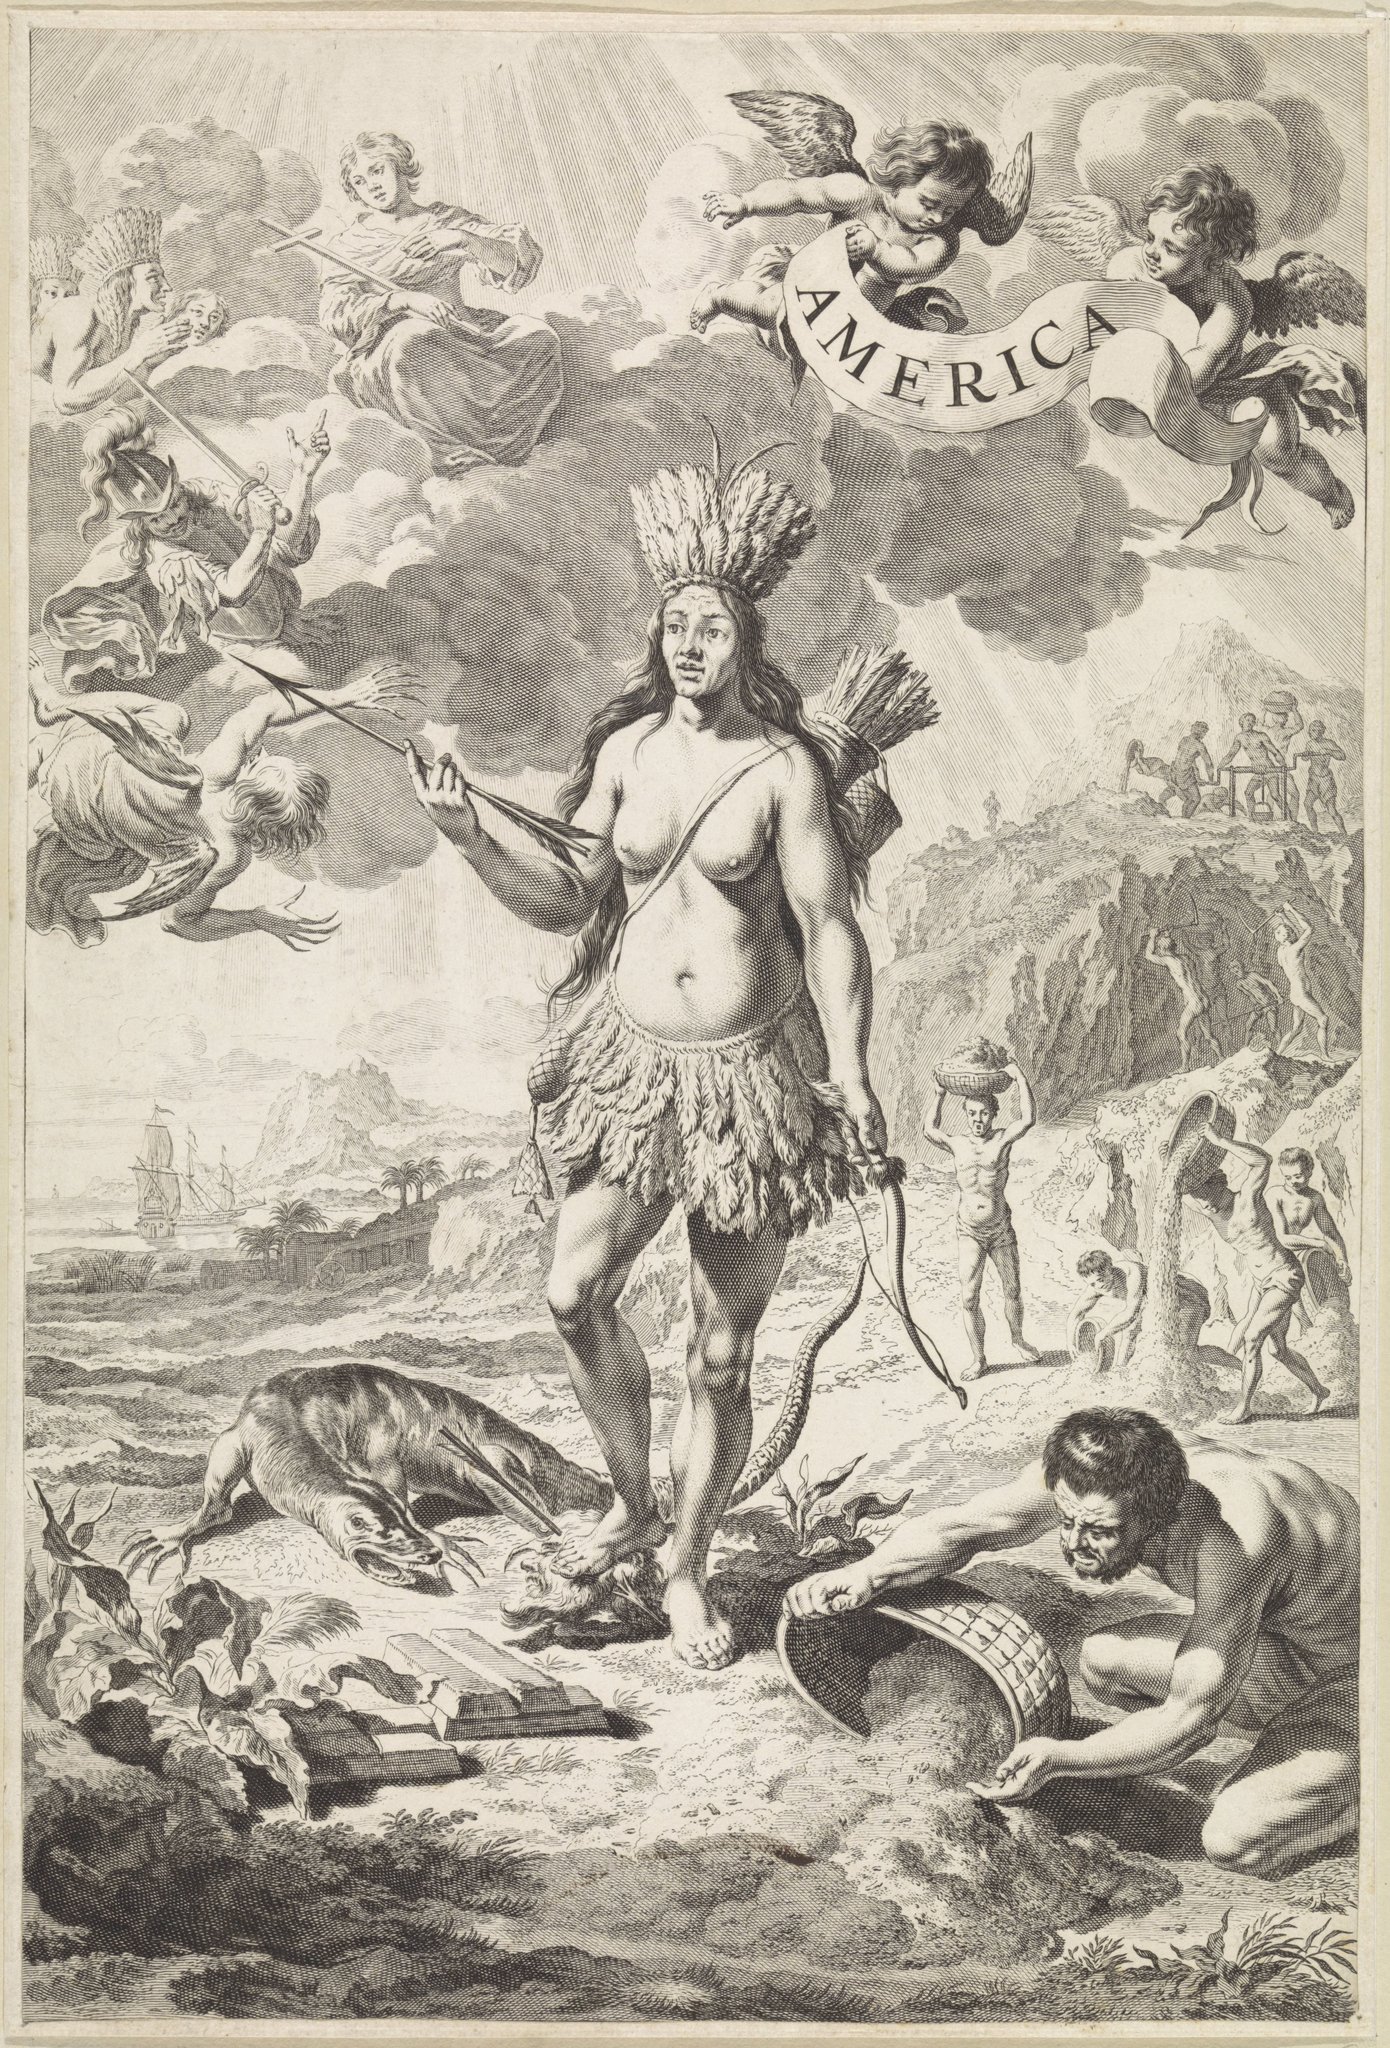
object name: print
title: Zuid Amerikaans landschap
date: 1650-1700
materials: paper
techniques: engraving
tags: sail, indigenous peoples of south america, cupids: 'amores', 'amoretti', 'putti'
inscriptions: collector's mark: Lugt 240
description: Gezicht op een rotsachtig Zuid Amerikaans landschap met op de voorgrond een vrouw met pijl en boog en een verentooi. Op de voor- en achtergrond zijn mensen aan het werk.